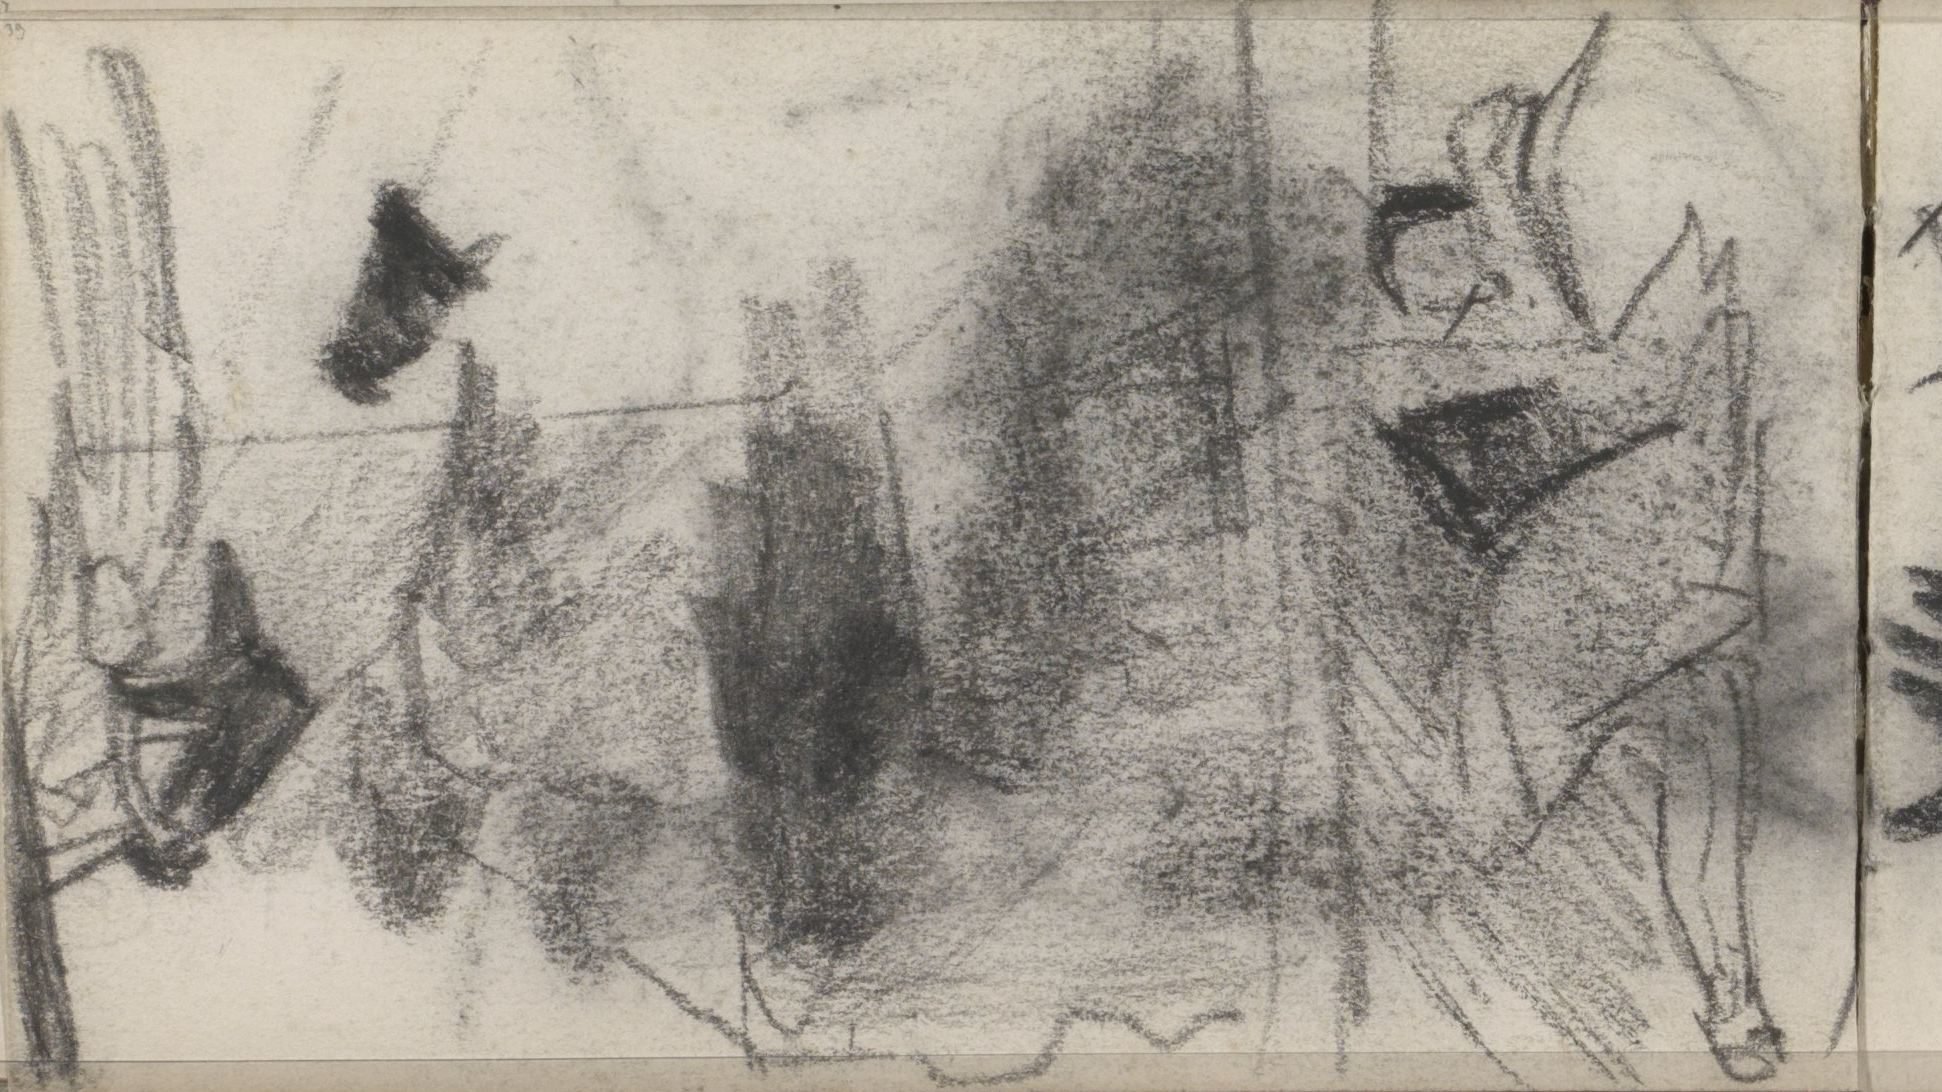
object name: sketchbook leaf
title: Figuren en een hond, mogelijk op een brug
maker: george hendrik breitner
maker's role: draughtsman, painter, print maker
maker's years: 1857-1923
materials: chalk, paper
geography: amsterdam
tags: girl (child between toddler and youth), lying figure - aa - female human figure, bridge in city across river, canal, etc., amsterdam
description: Ernaast een liggend meisje. Pagina 39 uit een schetsboek met 32 bladen.